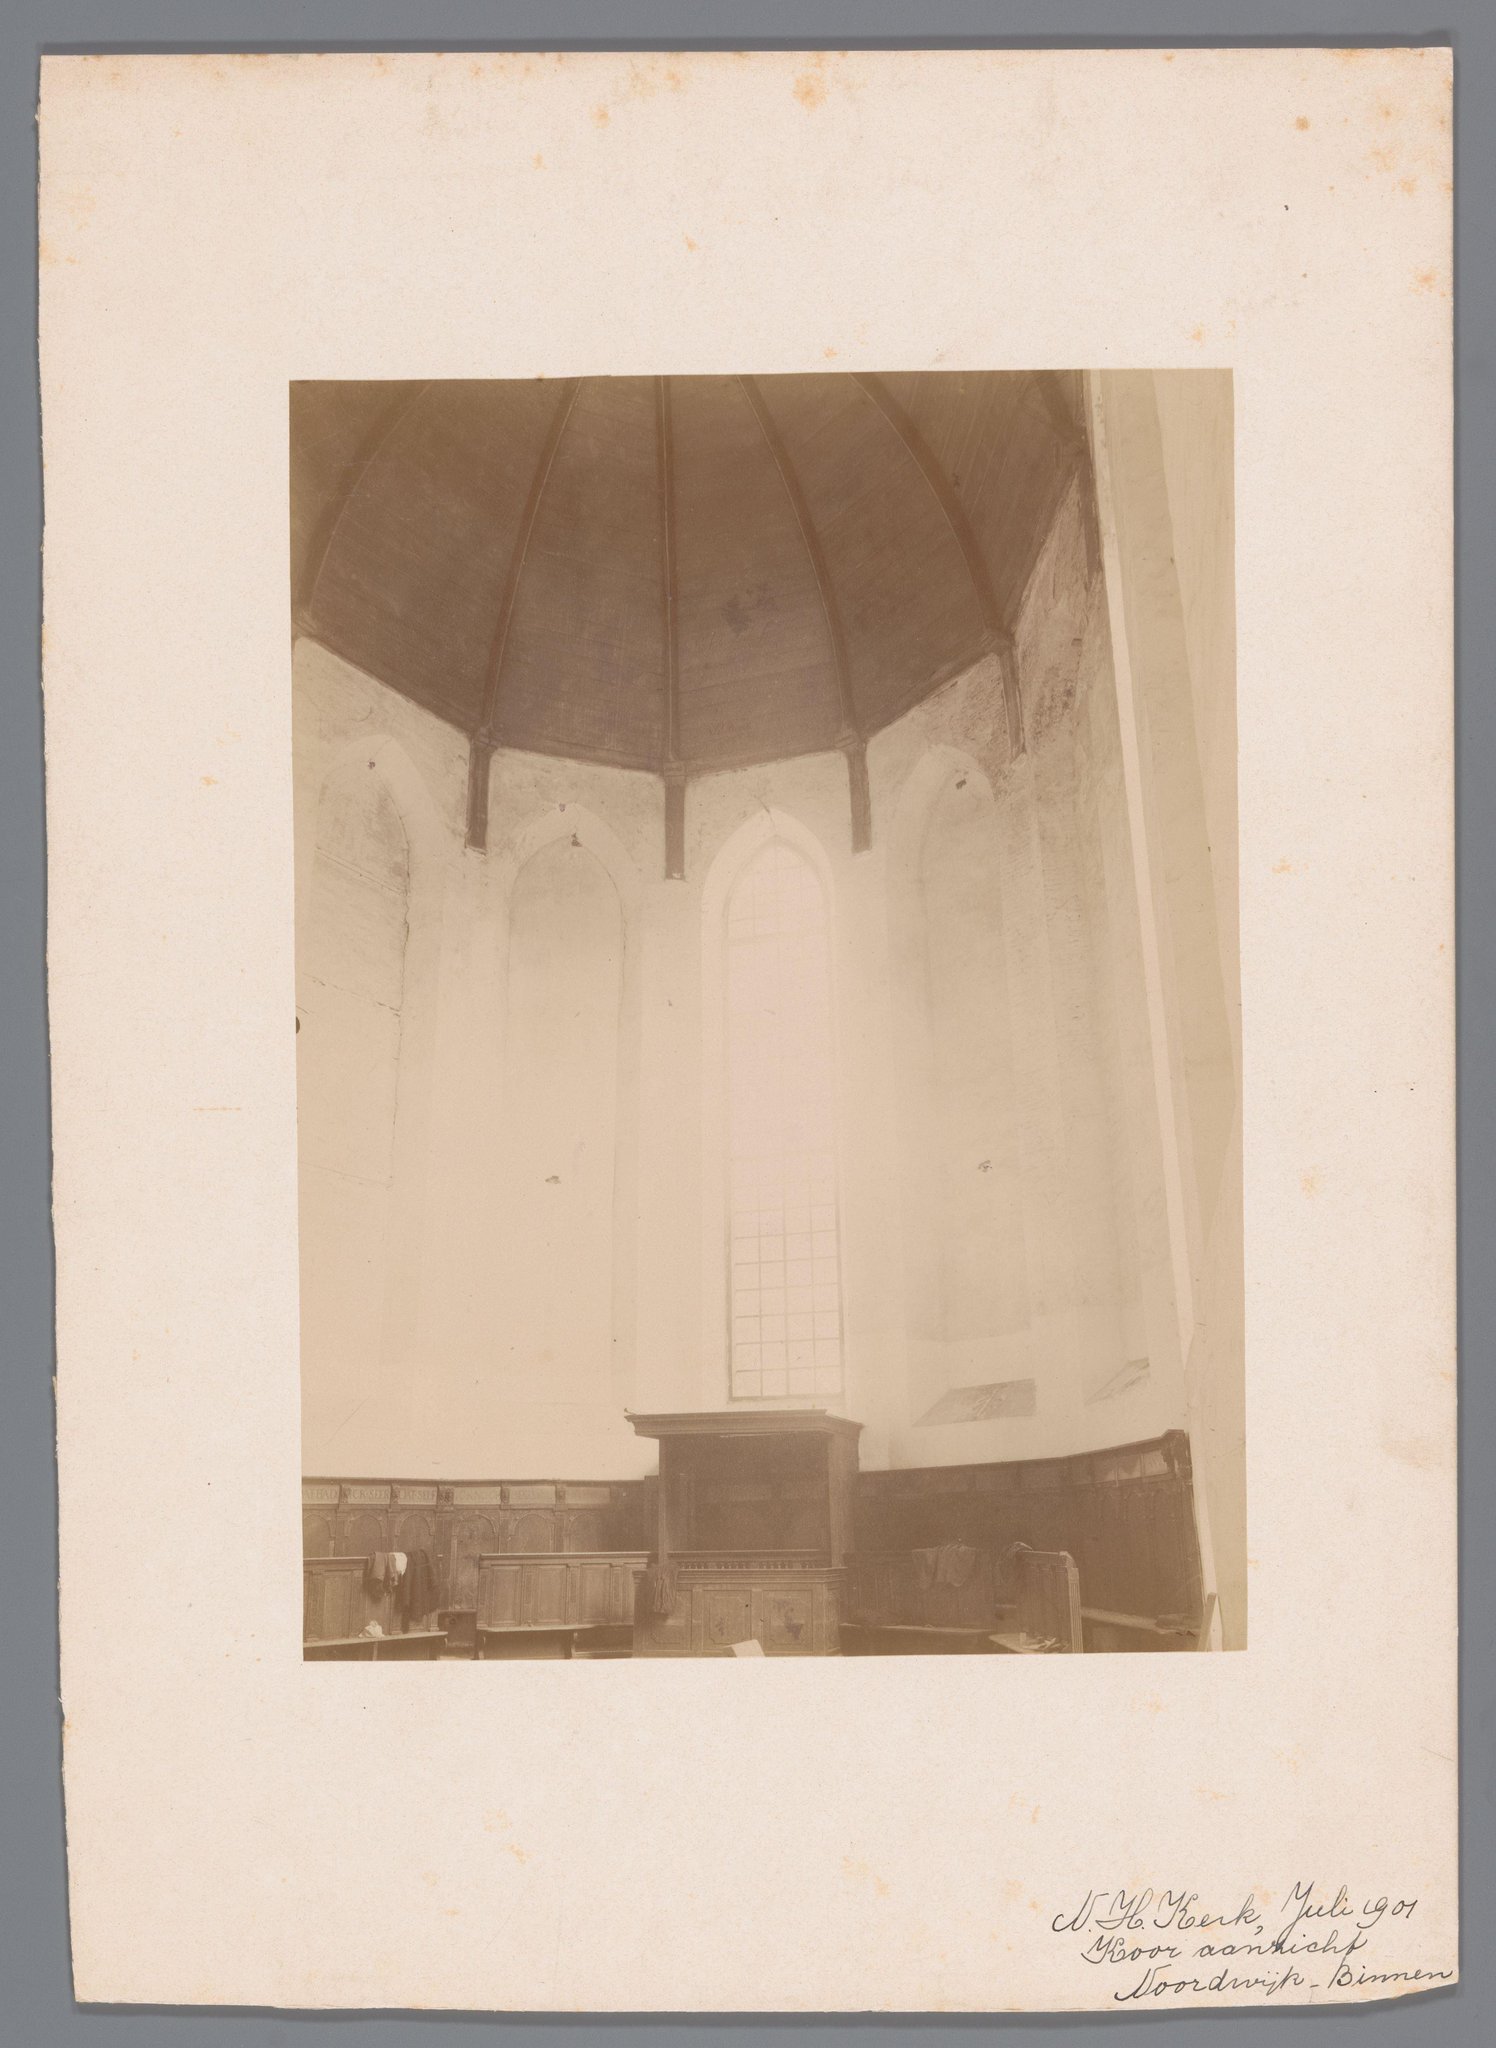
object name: photograph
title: Koor van de Hervormde Kerk van Noordwijk-Binnen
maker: anoniem (monumentenzorg)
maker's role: fotograaf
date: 1901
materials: cardboard, photographic support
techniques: albumen print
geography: noordwijk-binnen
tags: interior of church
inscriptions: annotation: ‘Noordwijk-binnen (Z.H.)/ N.H. kerk/ kooraanzicht/ Juli 1901’, annotation: ‘N.H. Kerk, Juli 1901/ koor aanzicht/ Noordwijk-Binnen’